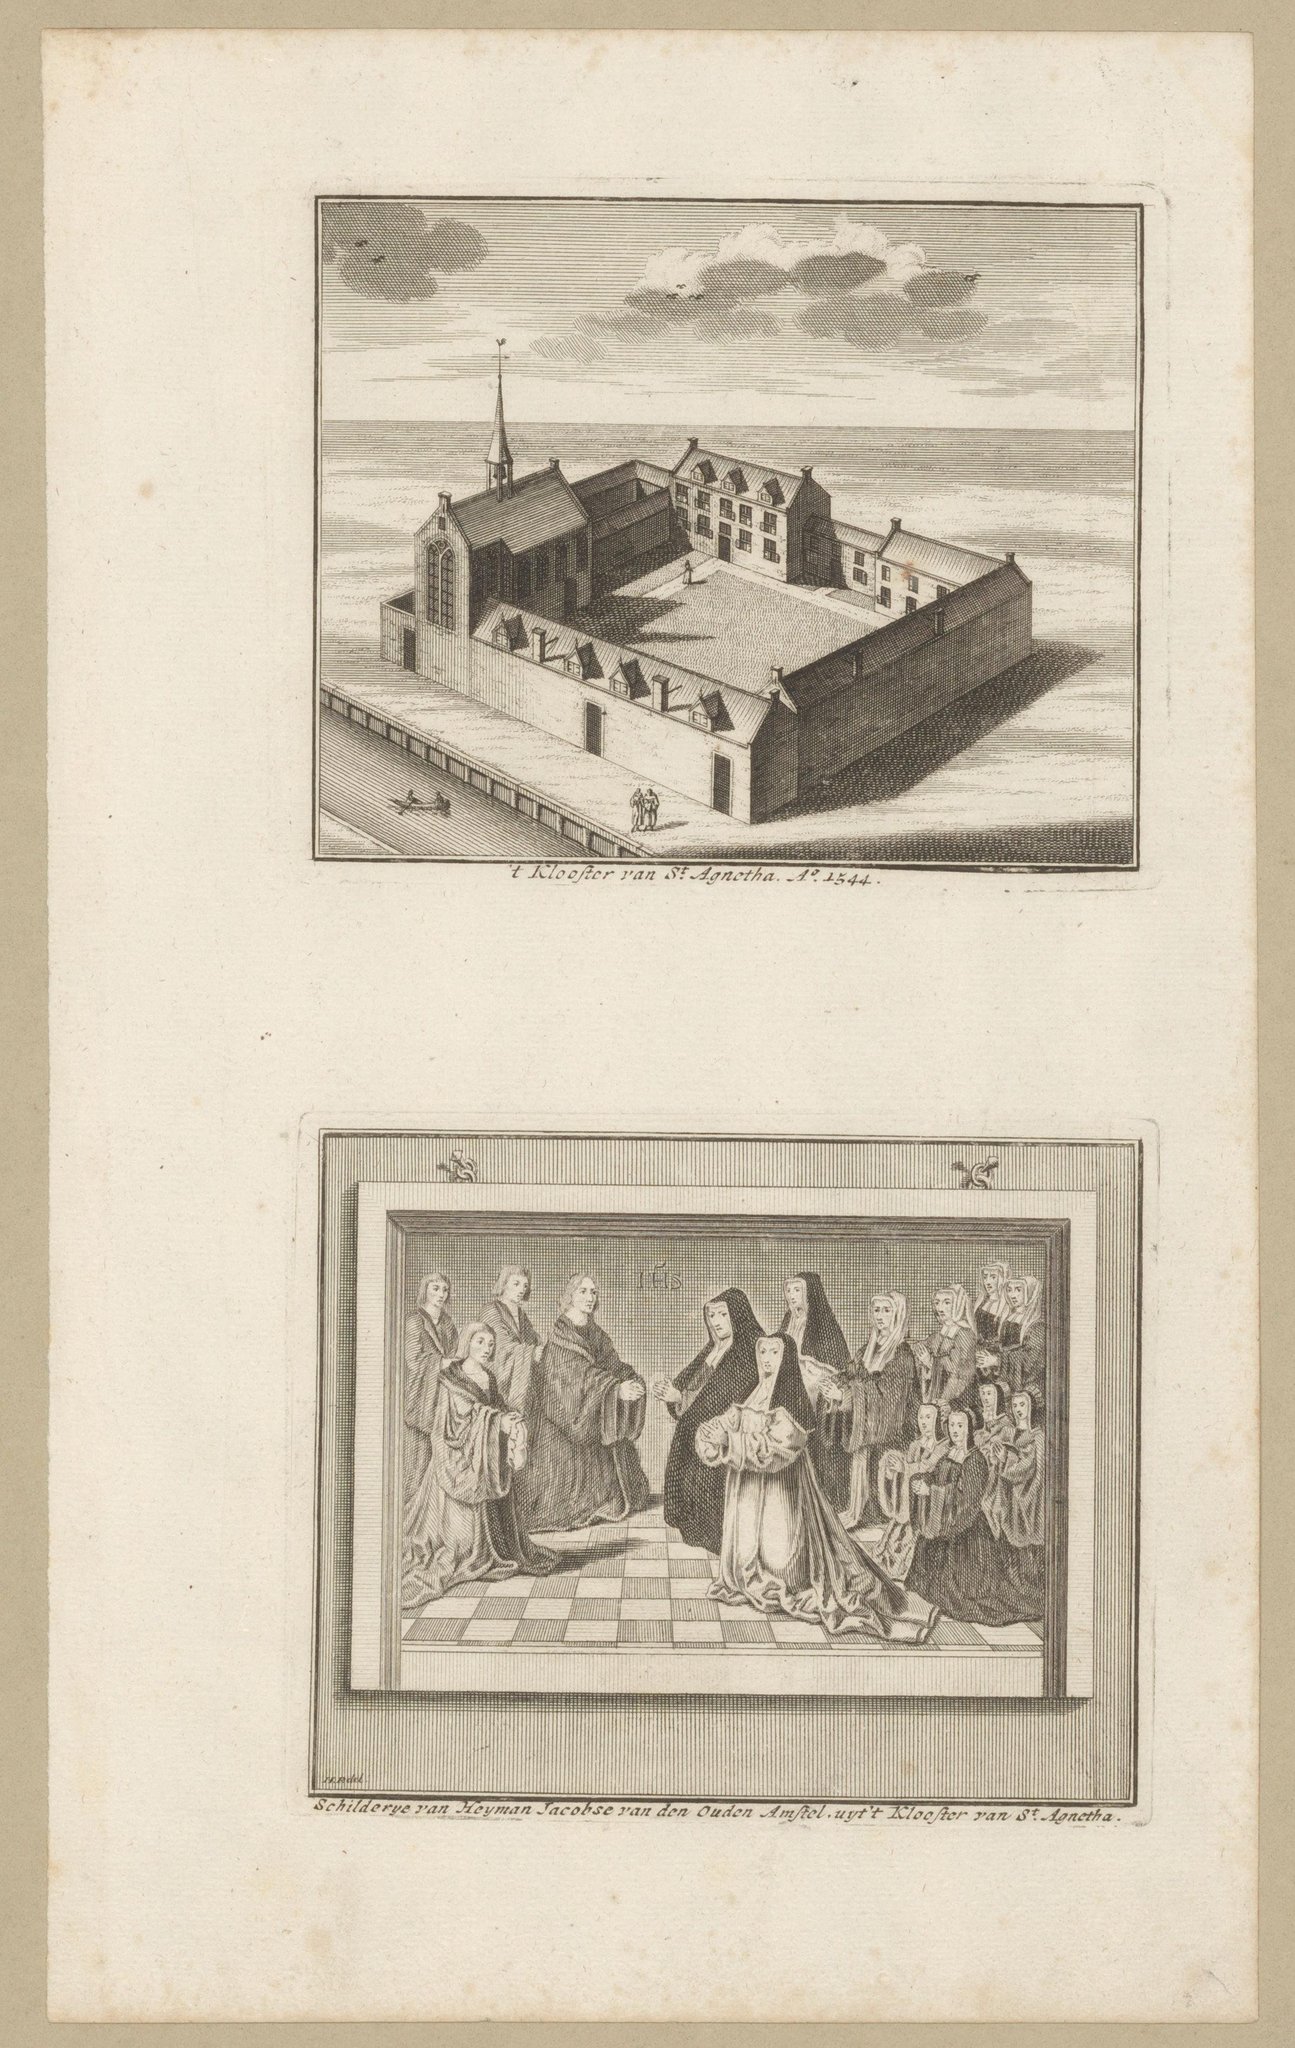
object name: print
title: Gezicht in vogelvlucht op het Agnietenklooster te Amsterdam, en mannelijke en vrouwelijke geestelijken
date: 1729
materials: paper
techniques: engraving, etching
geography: northern netherlands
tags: abbey, monastery, convent ~ roman catholic church, picture, painting, historical persons not known by name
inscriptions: collector's mark: Lugt 1641b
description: Prent mogelijk uit: Long, Isaac le. Historische beschryvinge van de reformatie der stadt Amsterdam (…). Amsterdam: Johannes van Septeren (I), 1729. Dat de prent de situatie rond 1544 weergeeft, gaat terug op het feit dat voor het maken van deze en andere prenten van kloosters en kerken van voor de Alteratie (1578) is uitgegaan van de plattegrond van Cornelis Anthonisz. uit 1544, zie RP-P-OB-70.399 en RP-P-AO-20-15.